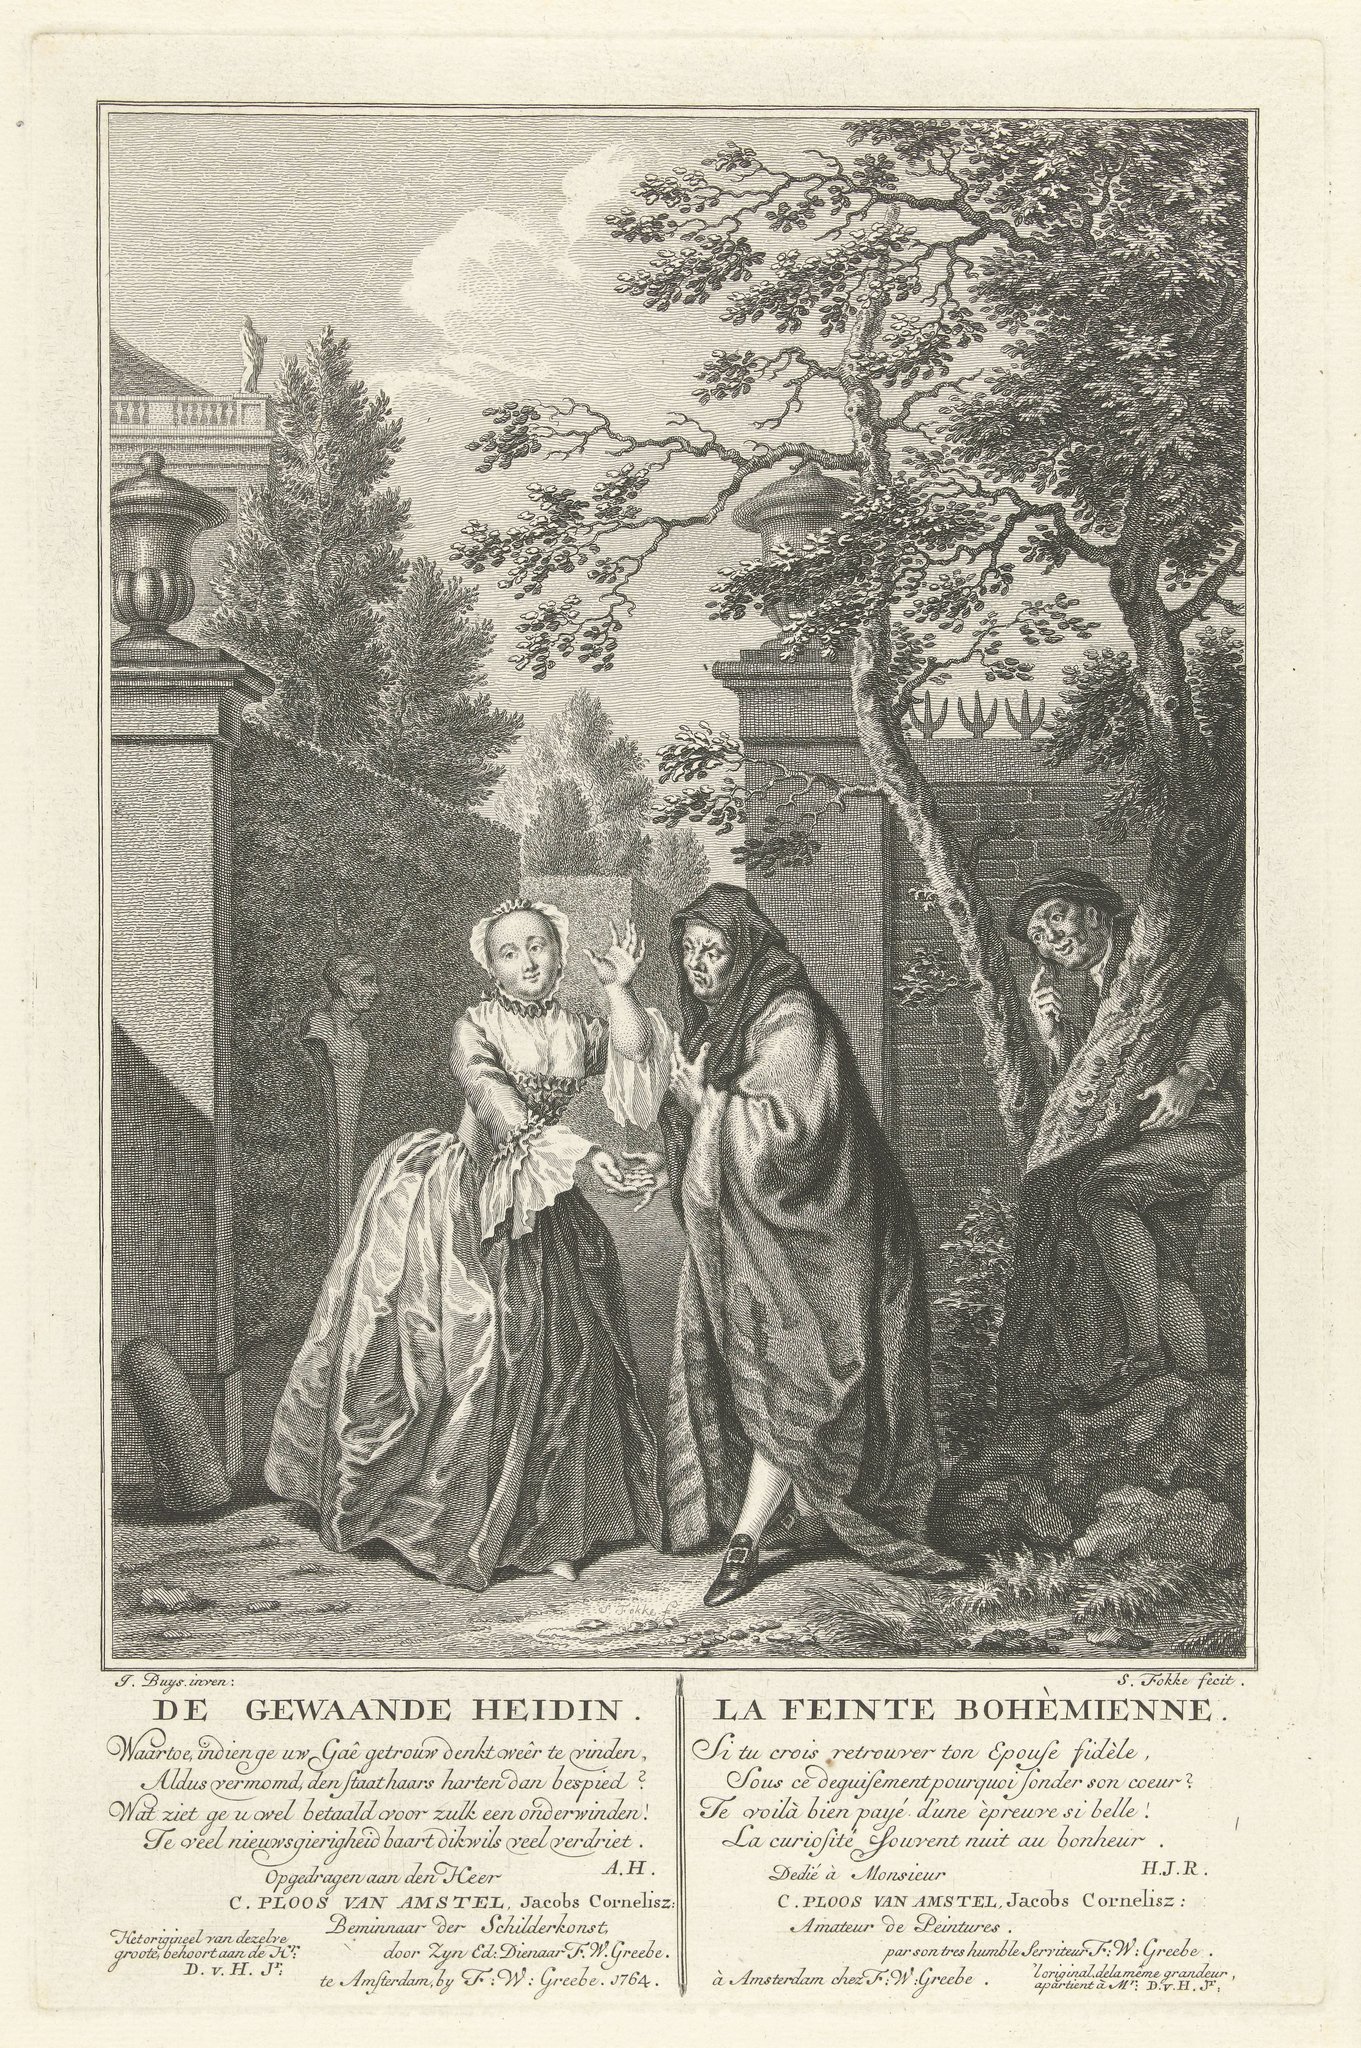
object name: print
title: Man en vrouw bij de ingang van een tuin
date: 1764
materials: paper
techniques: etching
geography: amsterdam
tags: wandering communities: romani or roma, disguise, satyr play, farce, gripping someone by the hand or the wrist; clasped hands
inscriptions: collector's mark: Lugt 240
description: Een vrouw heeft haar hand in die van een man gelegd. De man doet zich voor als een oude Roma vrouw (‘heiden’ was een eigentijdse benaming voor de Roma). Hij is volledig gehuld in een groot kleed, alleen zijn gezicht en schoenen zijn zichtbaar. Rechts achter een boom bespiedt een tweede man het paar. Op de achtergrond langs een hoge haag de ingang naar een tuin.